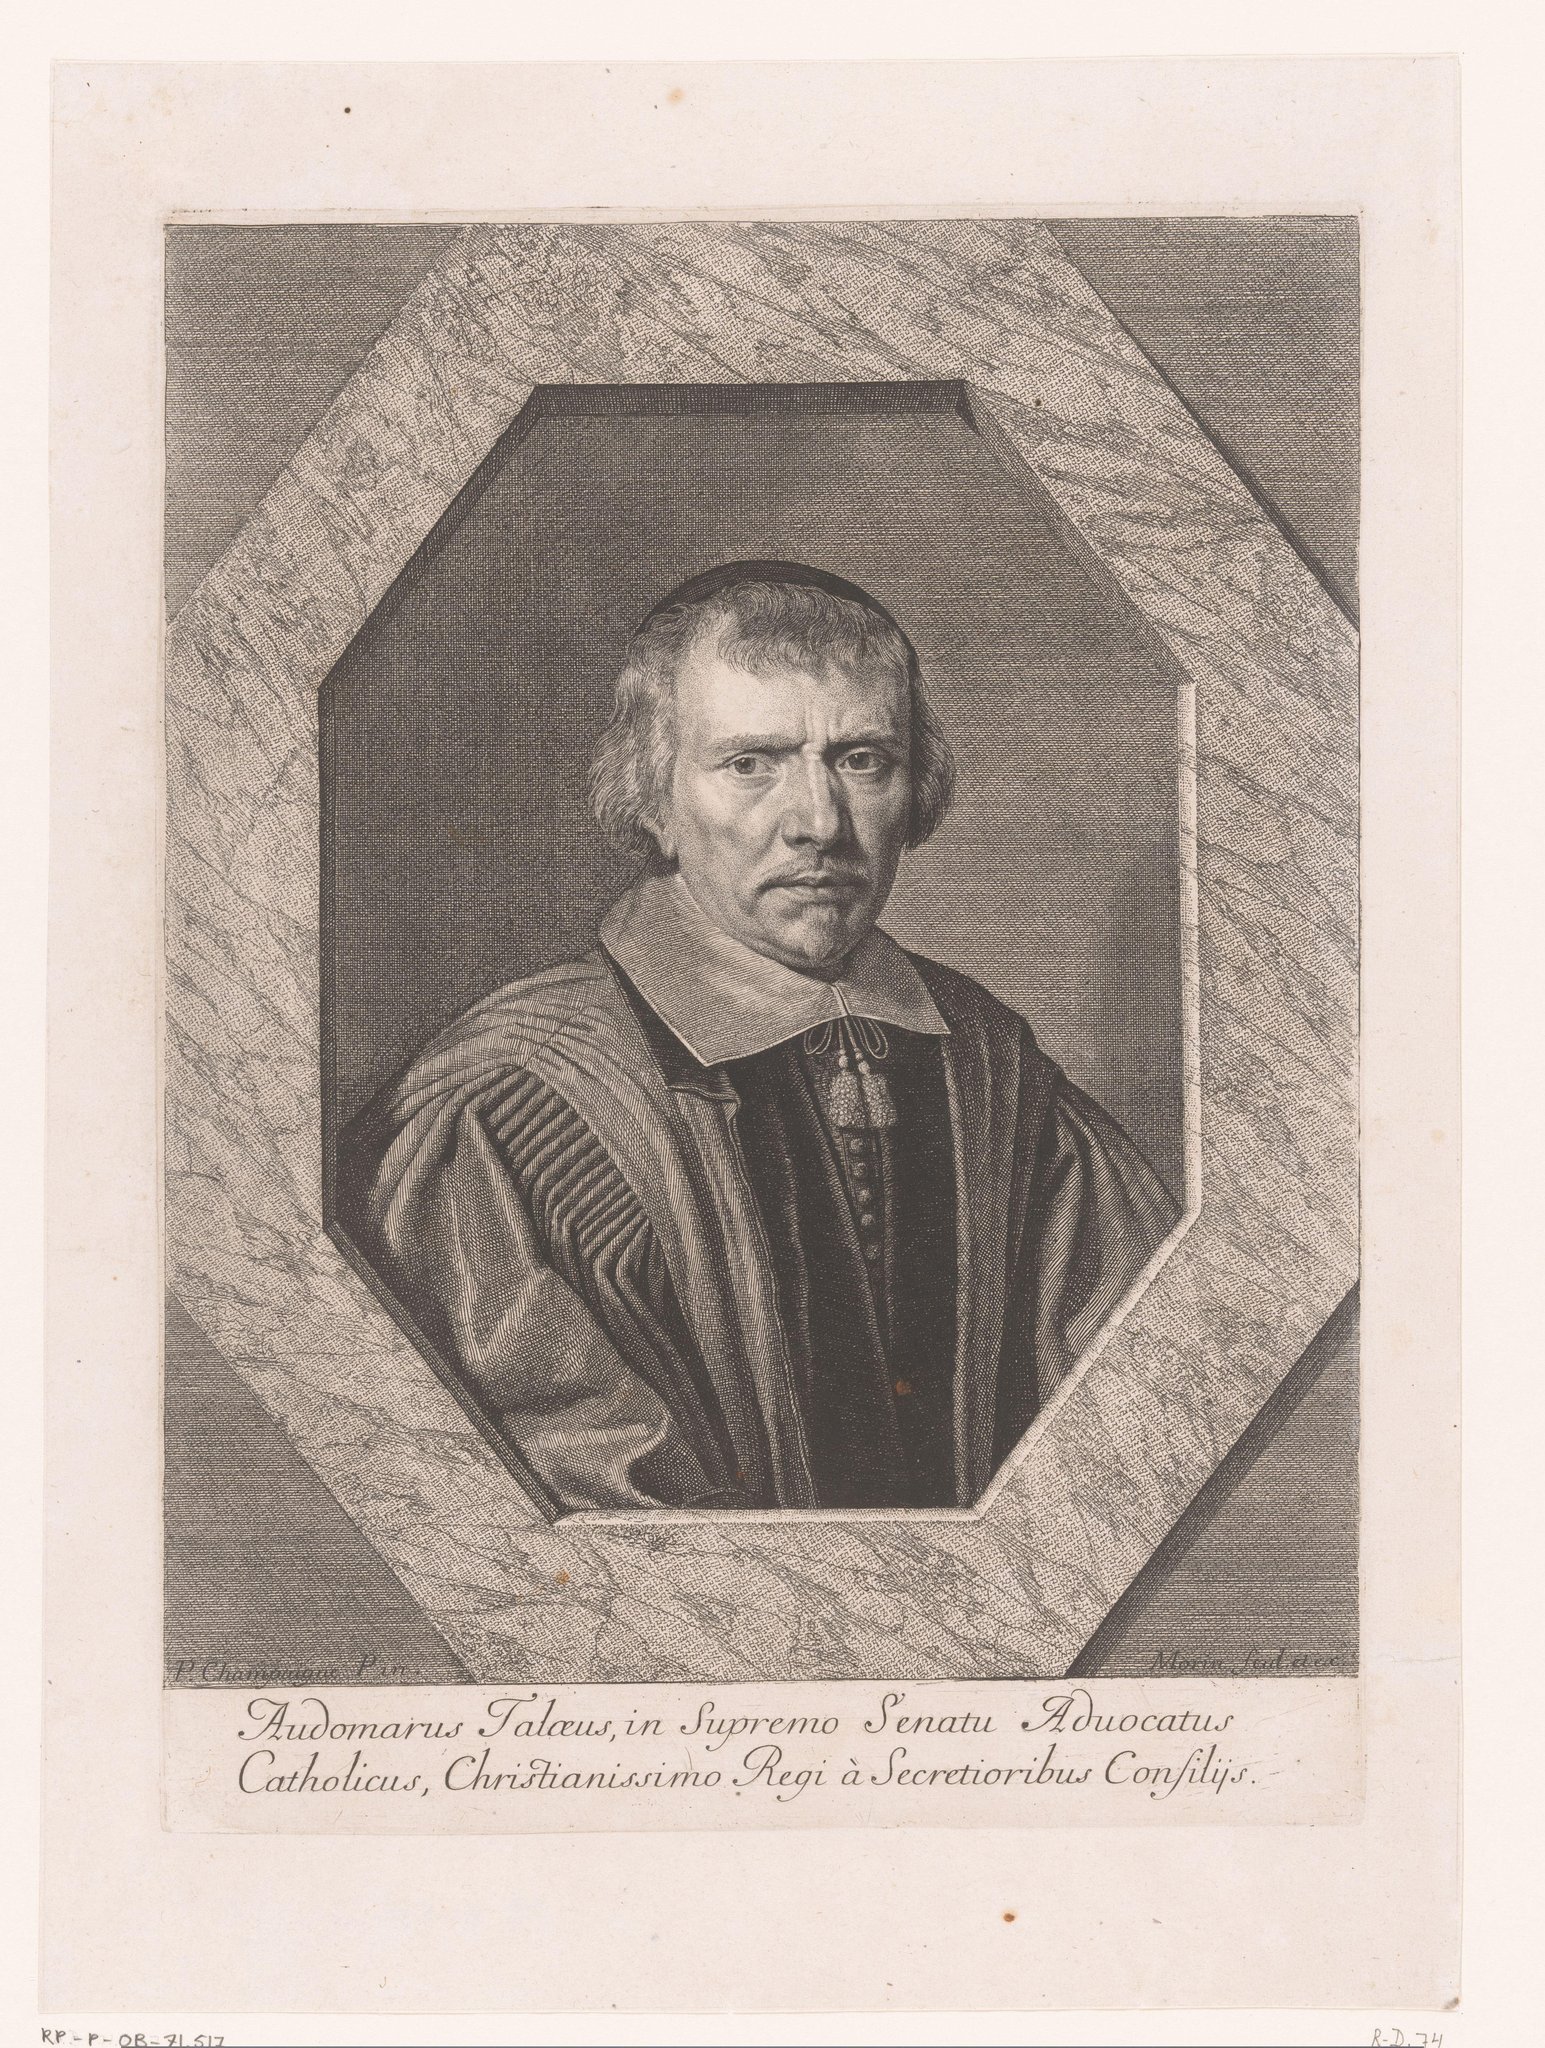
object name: print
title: Portret van Omer Talon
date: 1640-1650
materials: paper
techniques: etching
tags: historical persons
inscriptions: collector's mark: Lugt 2228